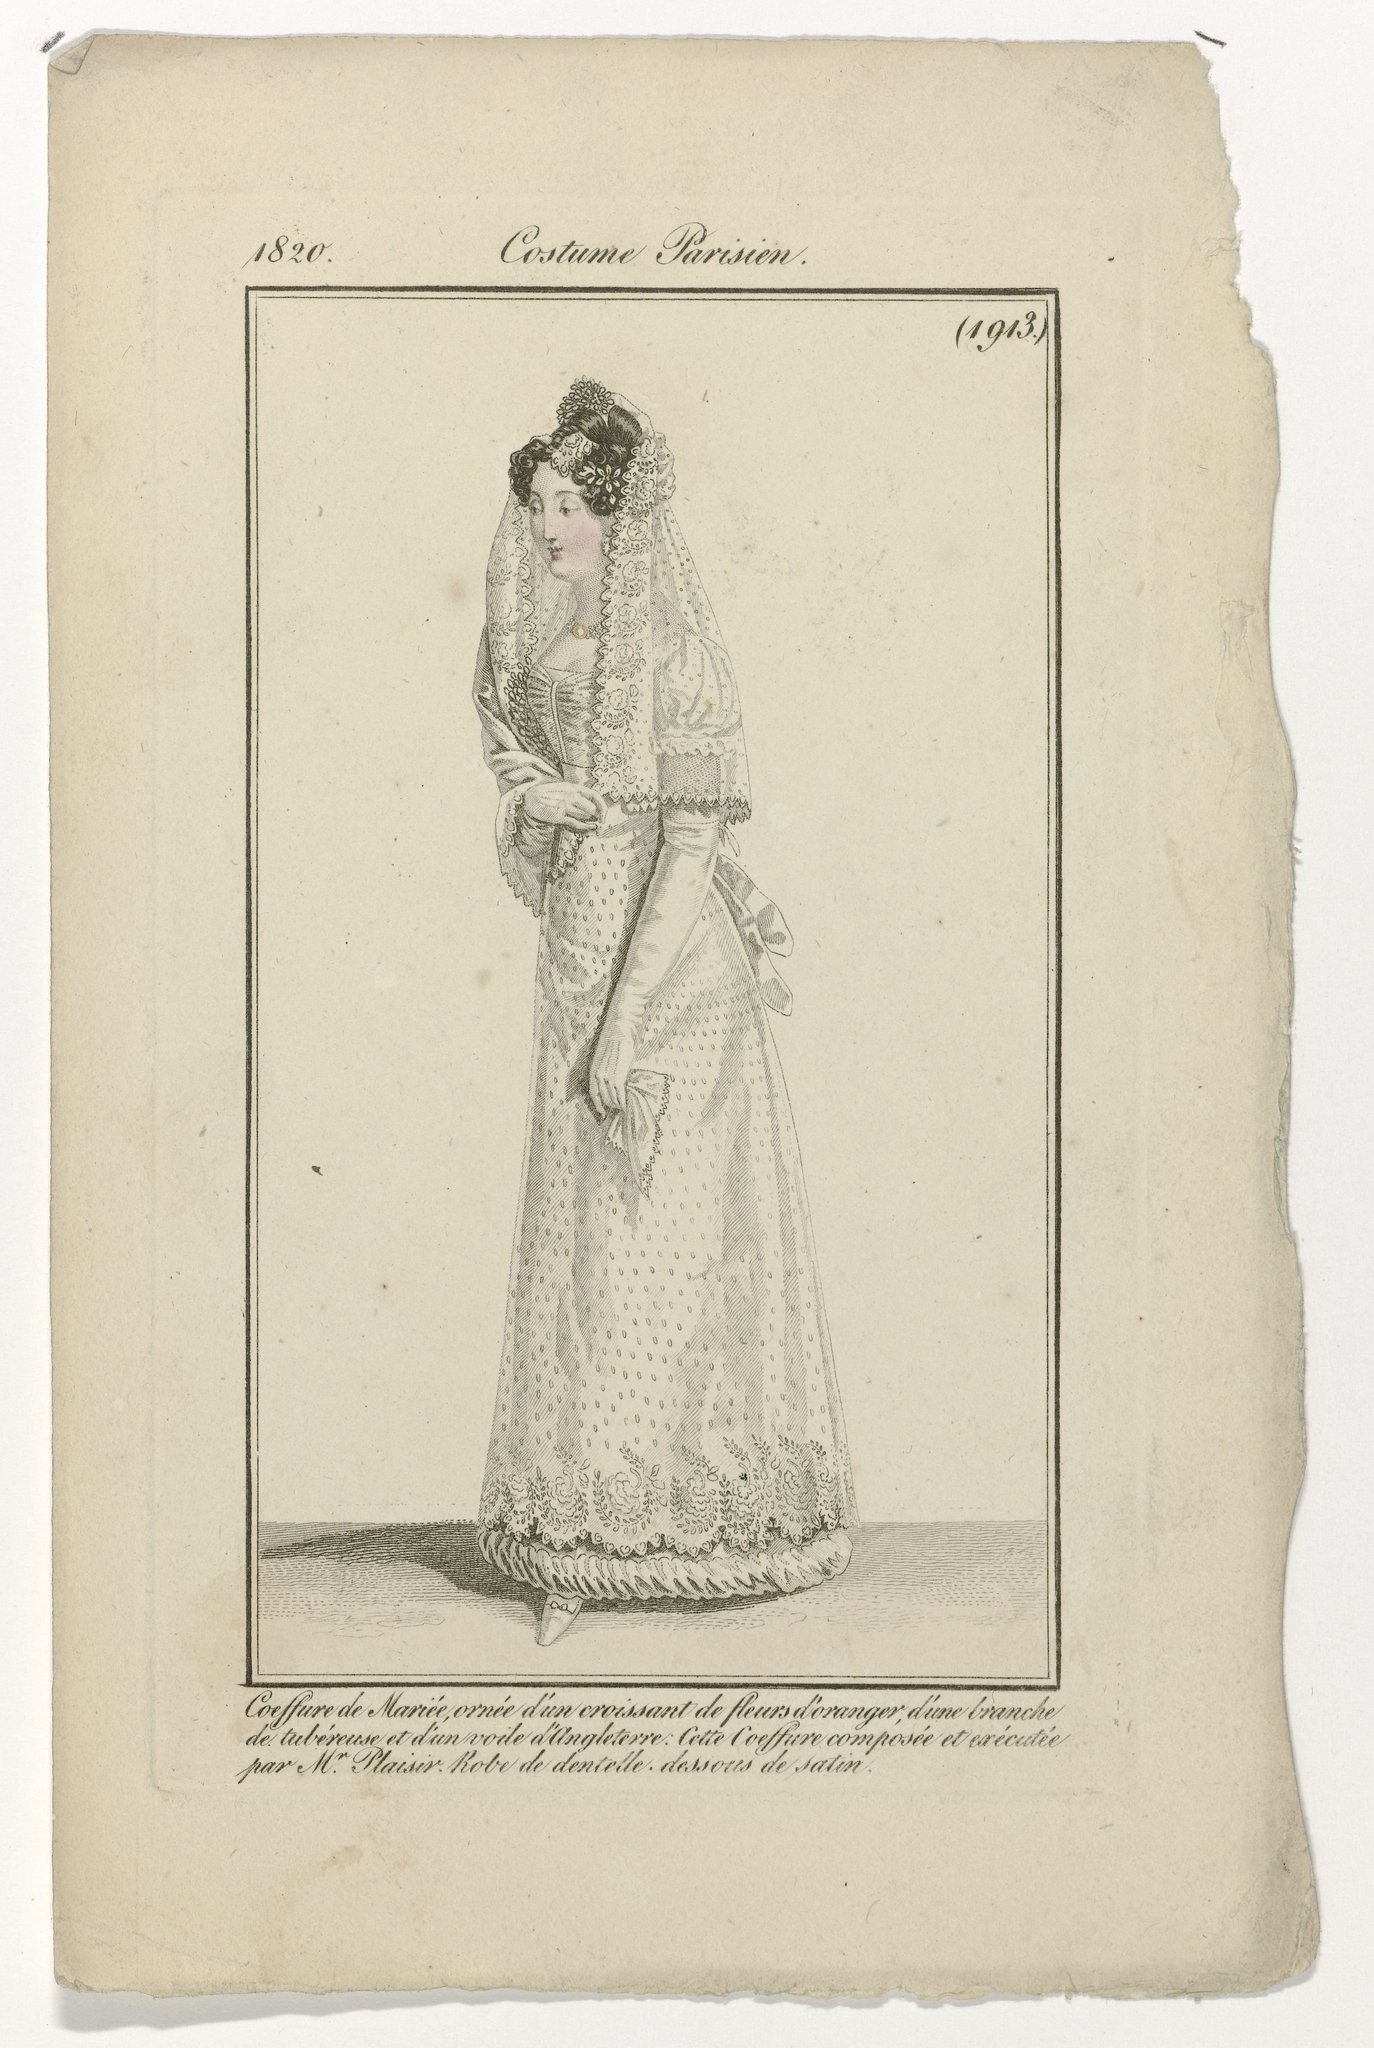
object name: fashion print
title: Journal des Dames et des Modes, Costume Parisien, 15 juillet 1820, (1913): Coeffure de Marié (...)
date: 1820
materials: paper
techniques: engraving, hand coloring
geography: paris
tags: handkerchief (+ women's clothes), gloves, mittens (long gloves) (+ women's clothes), veil (+ women's clothes), lace (+ women's clothes), styles of hairdress - aa - ~ women, fashion plates, shoes, sandals (+ women's clothes), bride (in wedding-dress), necklace (+ women's clothes)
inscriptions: caption: ‘Coeffure de Mariée, ornée d'un croissant de fleurs d'oranger, d'un branche de tubéreuse et d'un voile d'Angleterre. Cette Coeffure composée et exécutée par Mr. plaisir. Robe de dentelle, dessous de satin.’, title: ‘Costume Parisien.’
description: Vrouw, lopend naar links, gekleed in een een bruidsjapon van satijn overtrokken met kant. Korte pofmouwen. 'Coeffure de Mariée', versierd met een halve maan van oranjebloesem, een tak van tuberoos en een 'voile d'Angleterre'. De 'coeffure' is ontworpen en uitgevoerd door Mr Plaisir. Accessoires: collier, lange handschoenen, ceintuur(?), zakdoek, schoen met strik. De prent maakt deel uit van het modetijdschrift Journal des Dames et des Modes, uitgegeven door Pierre de la Mésangère, Parijs, 1797-1839.